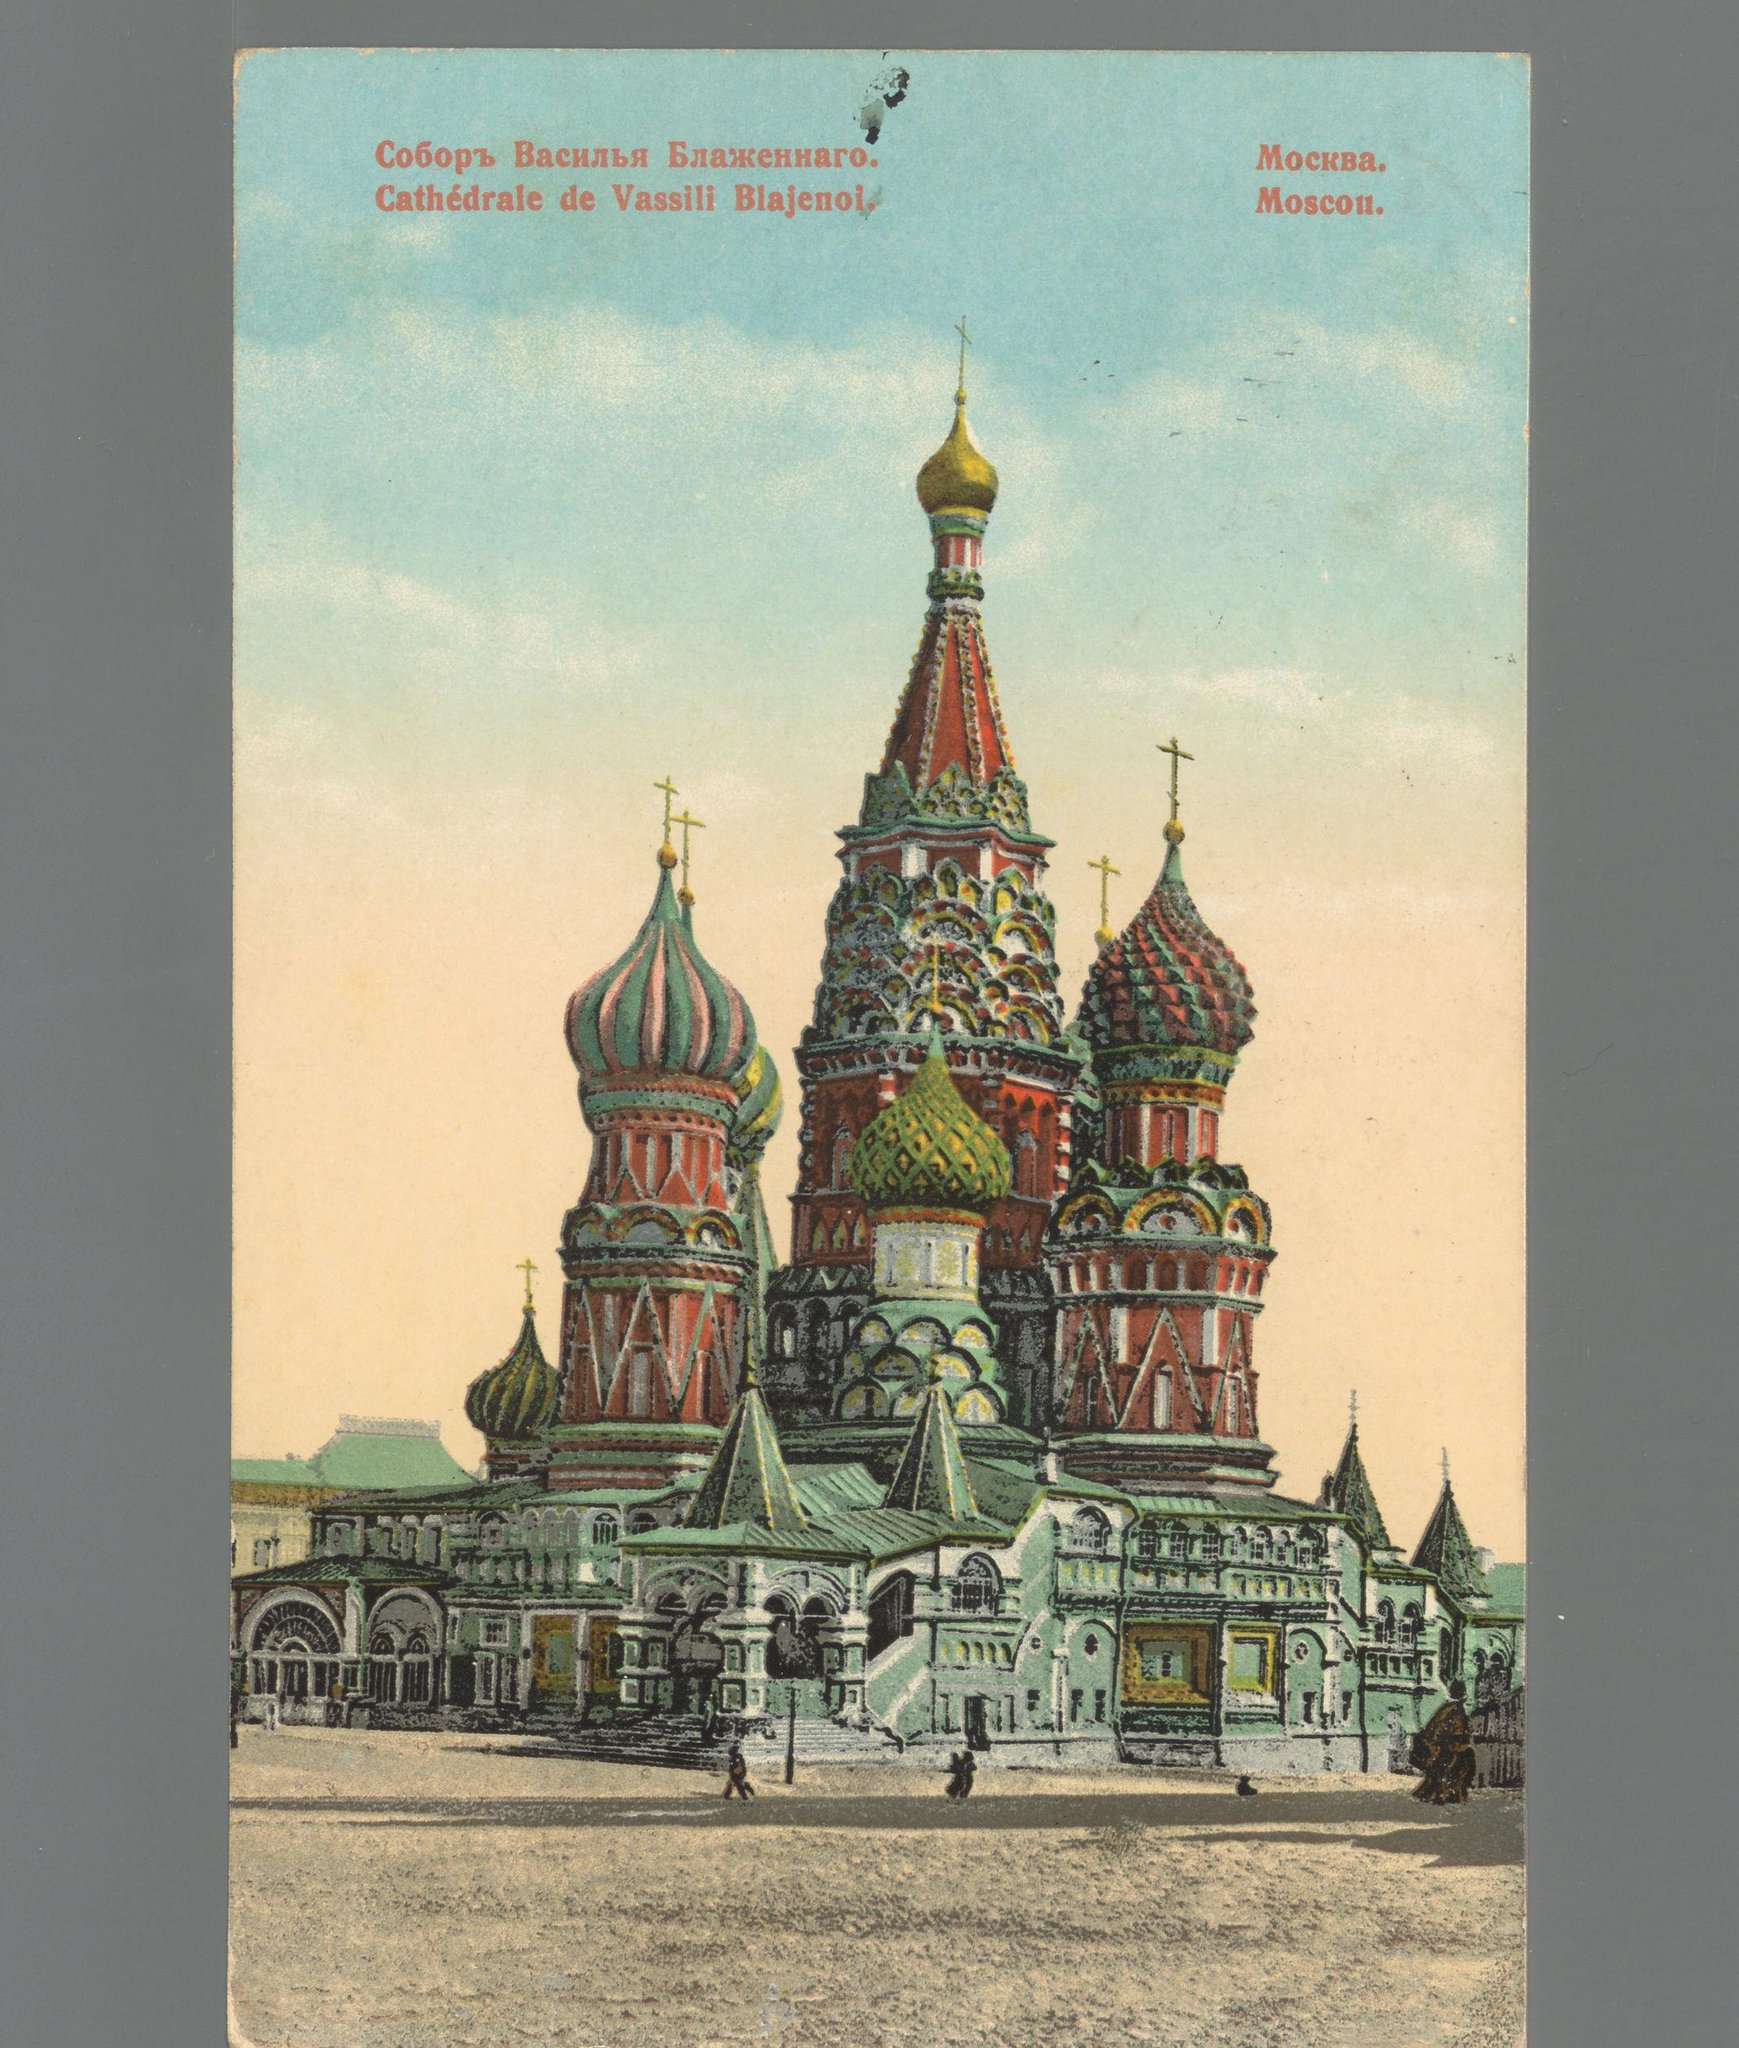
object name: photomechanical print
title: Cathédrale de Vassili Blajenoi. Moscou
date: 1904-1913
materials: cardboard, photographic process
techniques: writing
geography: moscow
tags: church (exterior)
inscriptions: postage stamp, monogram: ‘KAG’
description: Boven de Franse titel staat de titel in het Russisch.